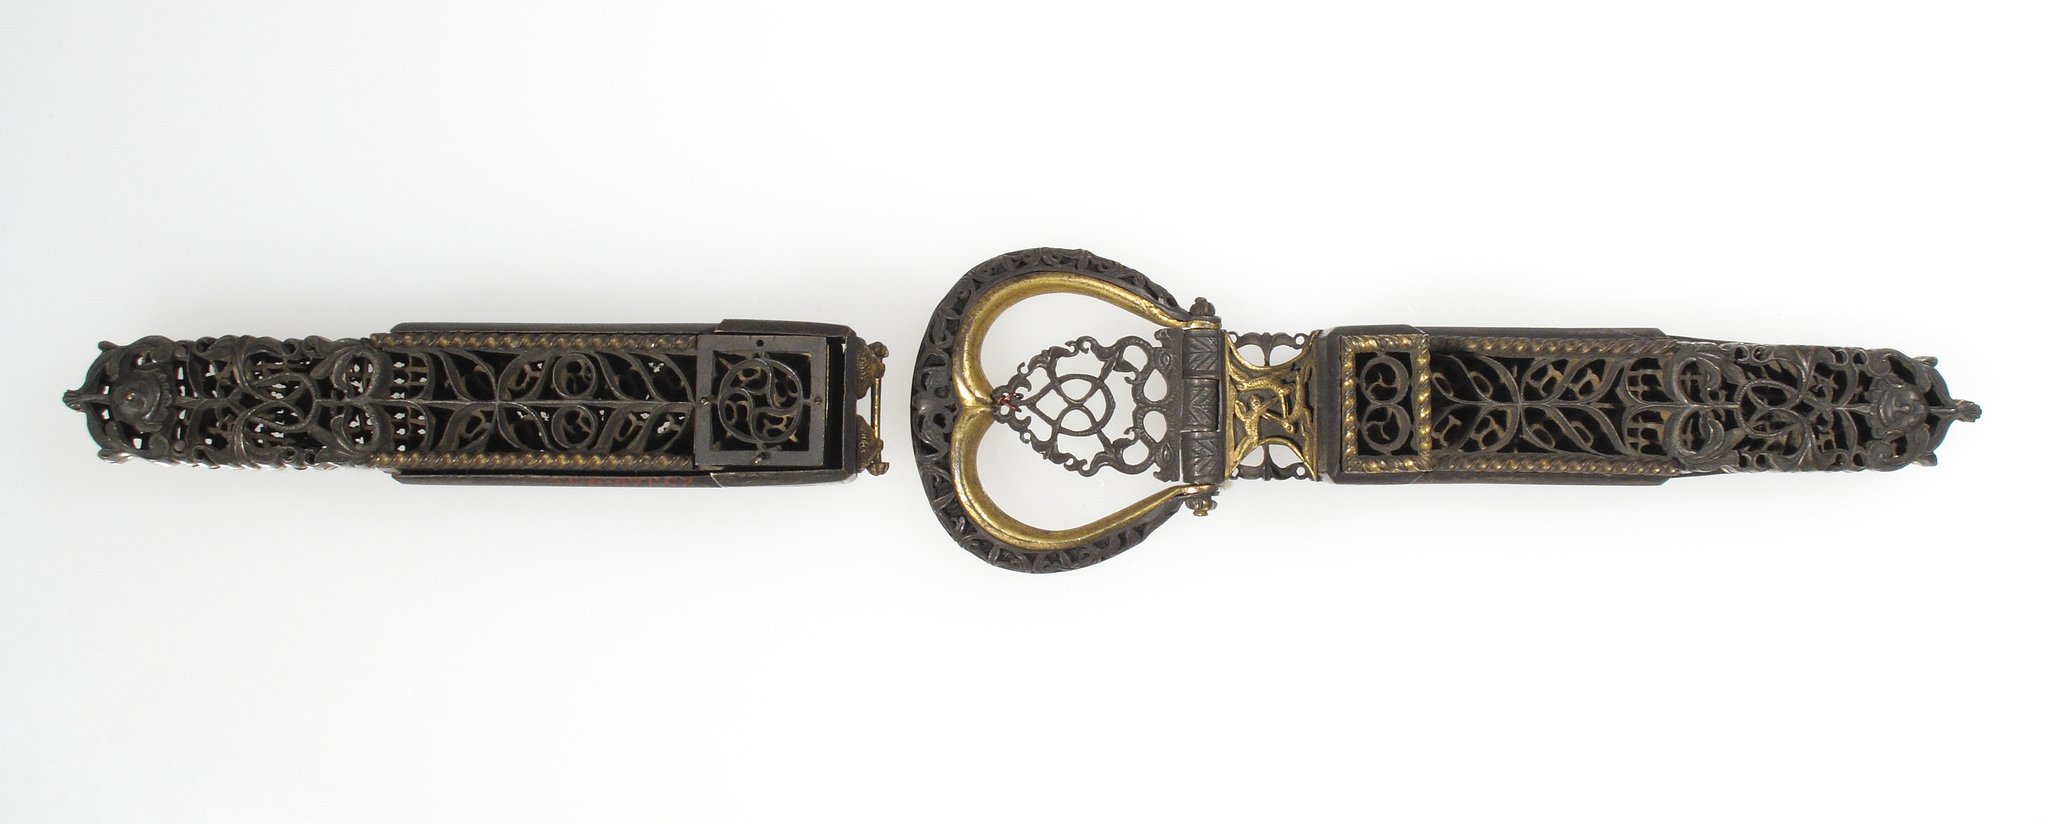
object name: buckle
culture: french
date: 1708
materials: copper alloy, steel